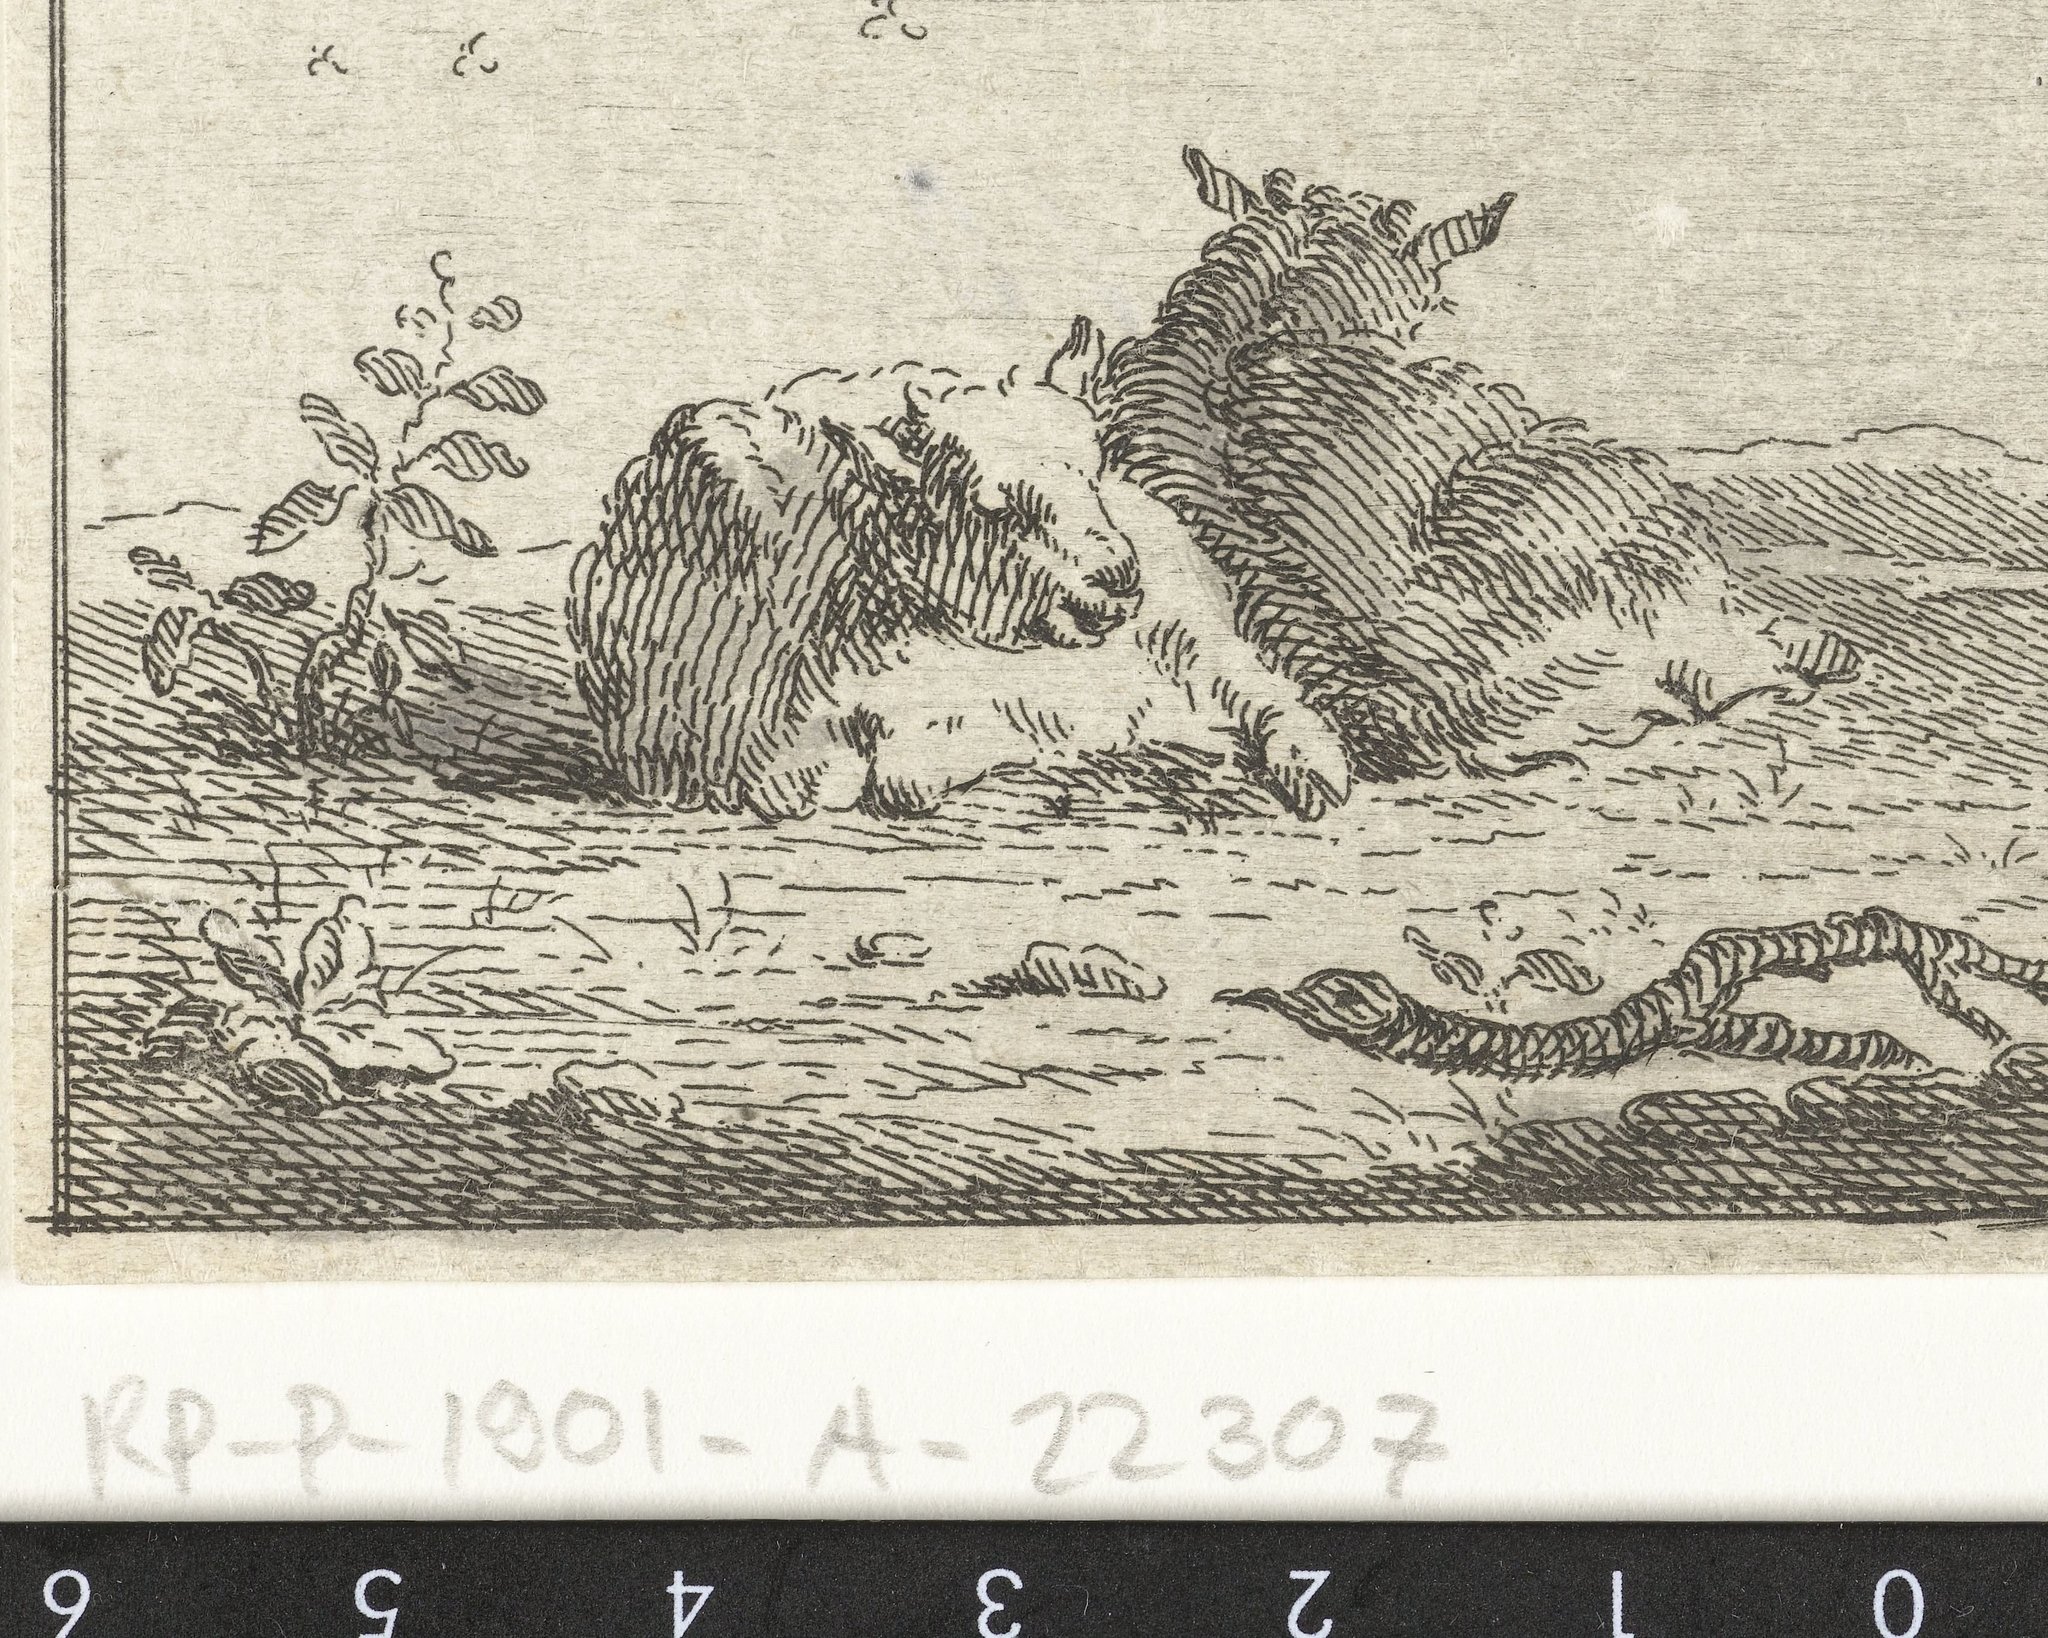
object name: print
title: Twee liggende schapen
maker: jan matthias cok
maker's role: draughtsman, print maker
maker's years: 1720-1771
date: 1735-1771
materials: paper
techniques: etching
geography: amsterdam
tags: sheep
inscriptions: number: ‘10’, collector's mark: Lugt 2228